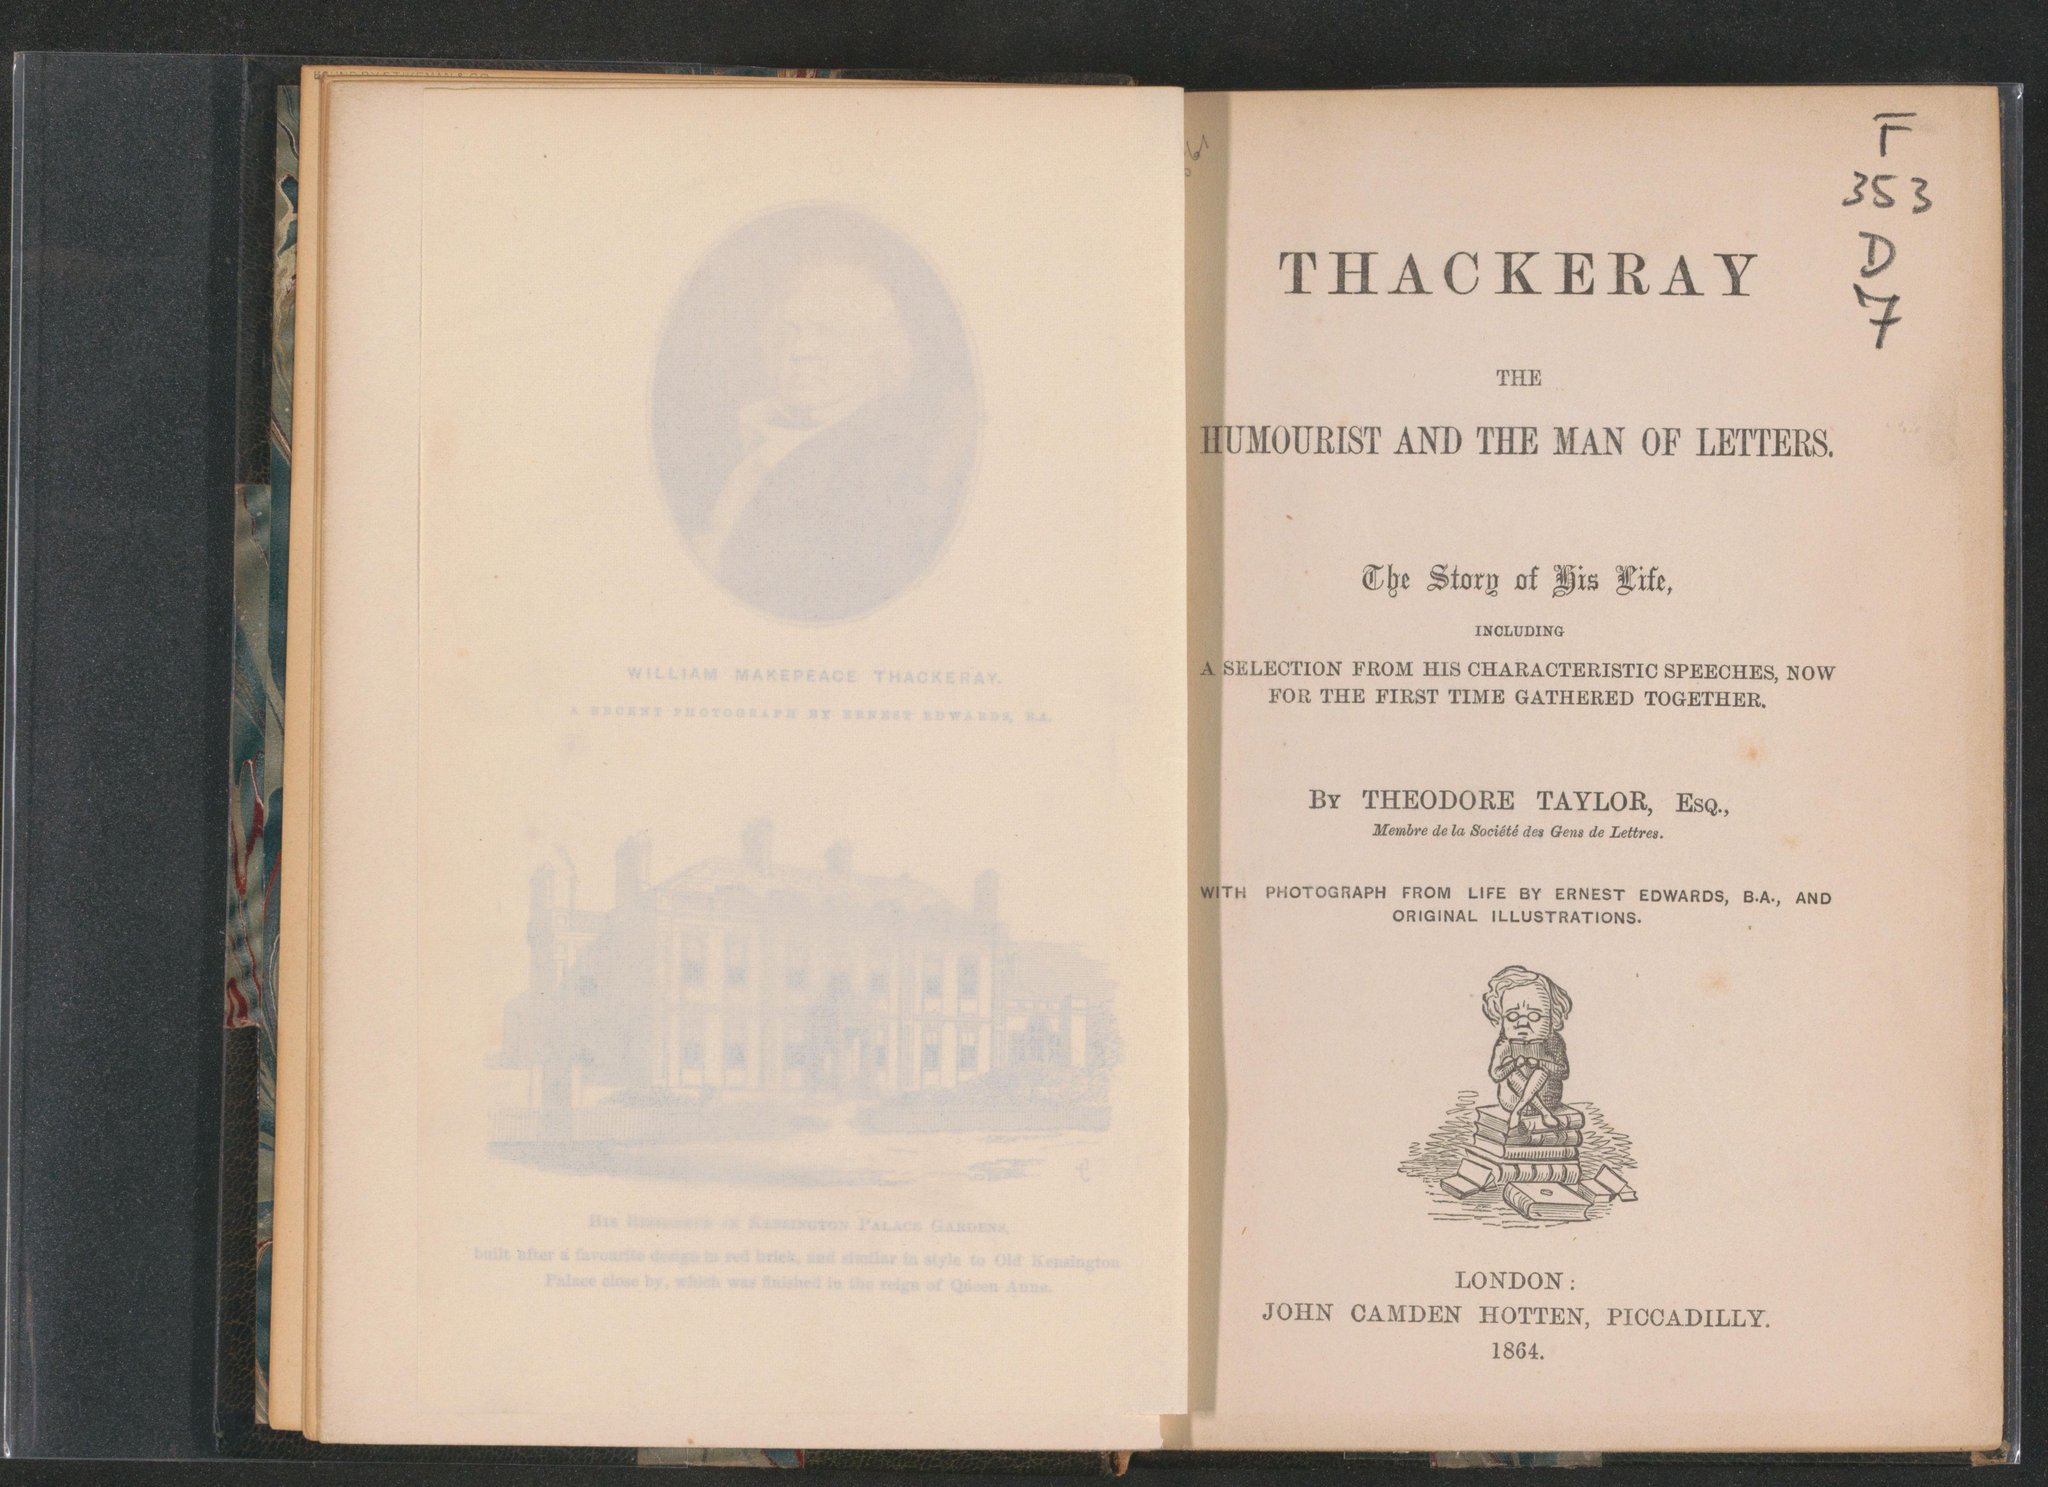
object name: book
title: Thackeray the humourist and the man of letters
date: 1864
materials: cardboard, linen, paper, photographic support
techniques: albumen print, engraving, etching, printing, marbled paper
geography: london